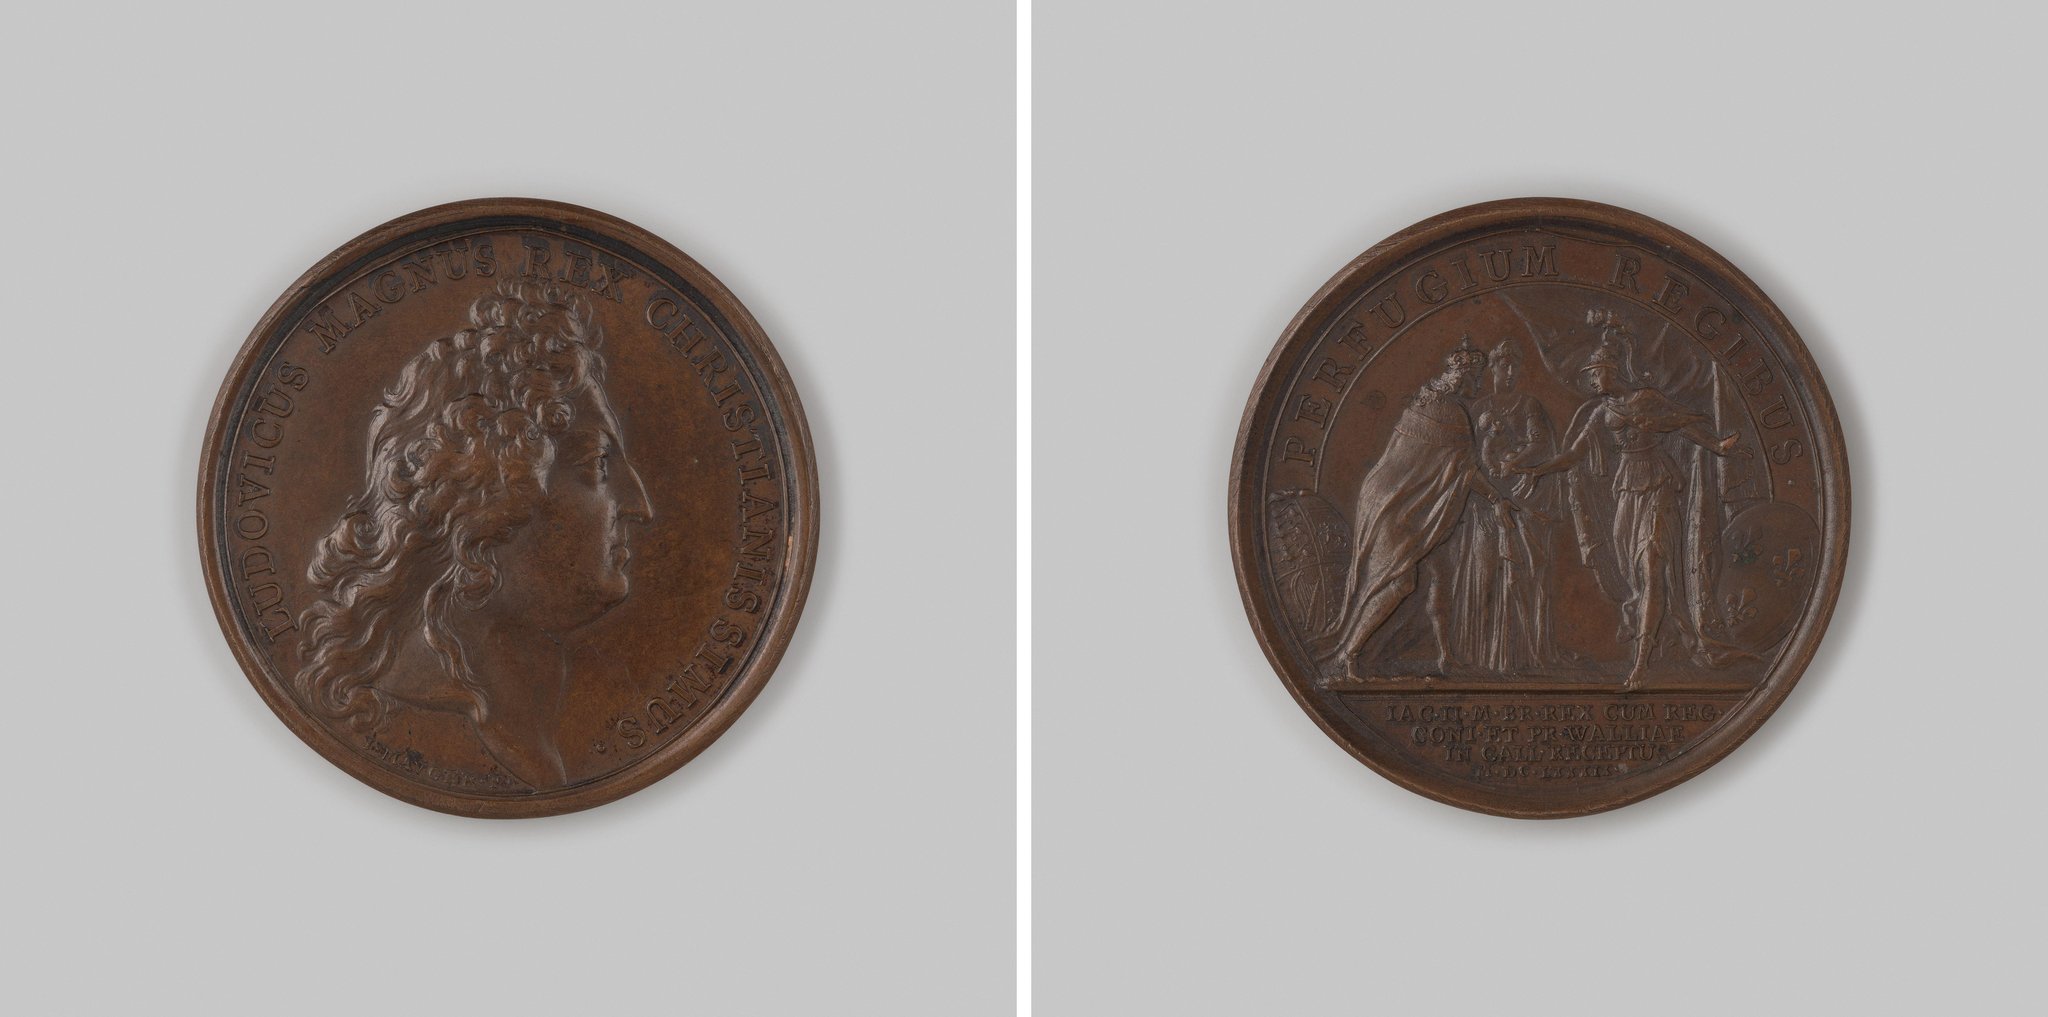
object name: history medal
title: Jacobus II gastvrij ontvangen in Frankrijk door Lodewijk XIV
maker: jean mauger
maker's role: medailleur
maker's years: 1648-1722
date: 1699-1703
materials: bronze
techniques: striking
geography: paris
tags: jacobus ii (koning van engeland en schotland), lodewijk xiv (koning van frankrijk), rome, france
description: Bronzen penning. Voorzijde: borststuk man binnen omschrift. Keerzijde: gehelmde Frankrijk naast wapenschild ontvangt gevluchte koning met vrouw en zoon binnen omschrift; afsnede: opschrift